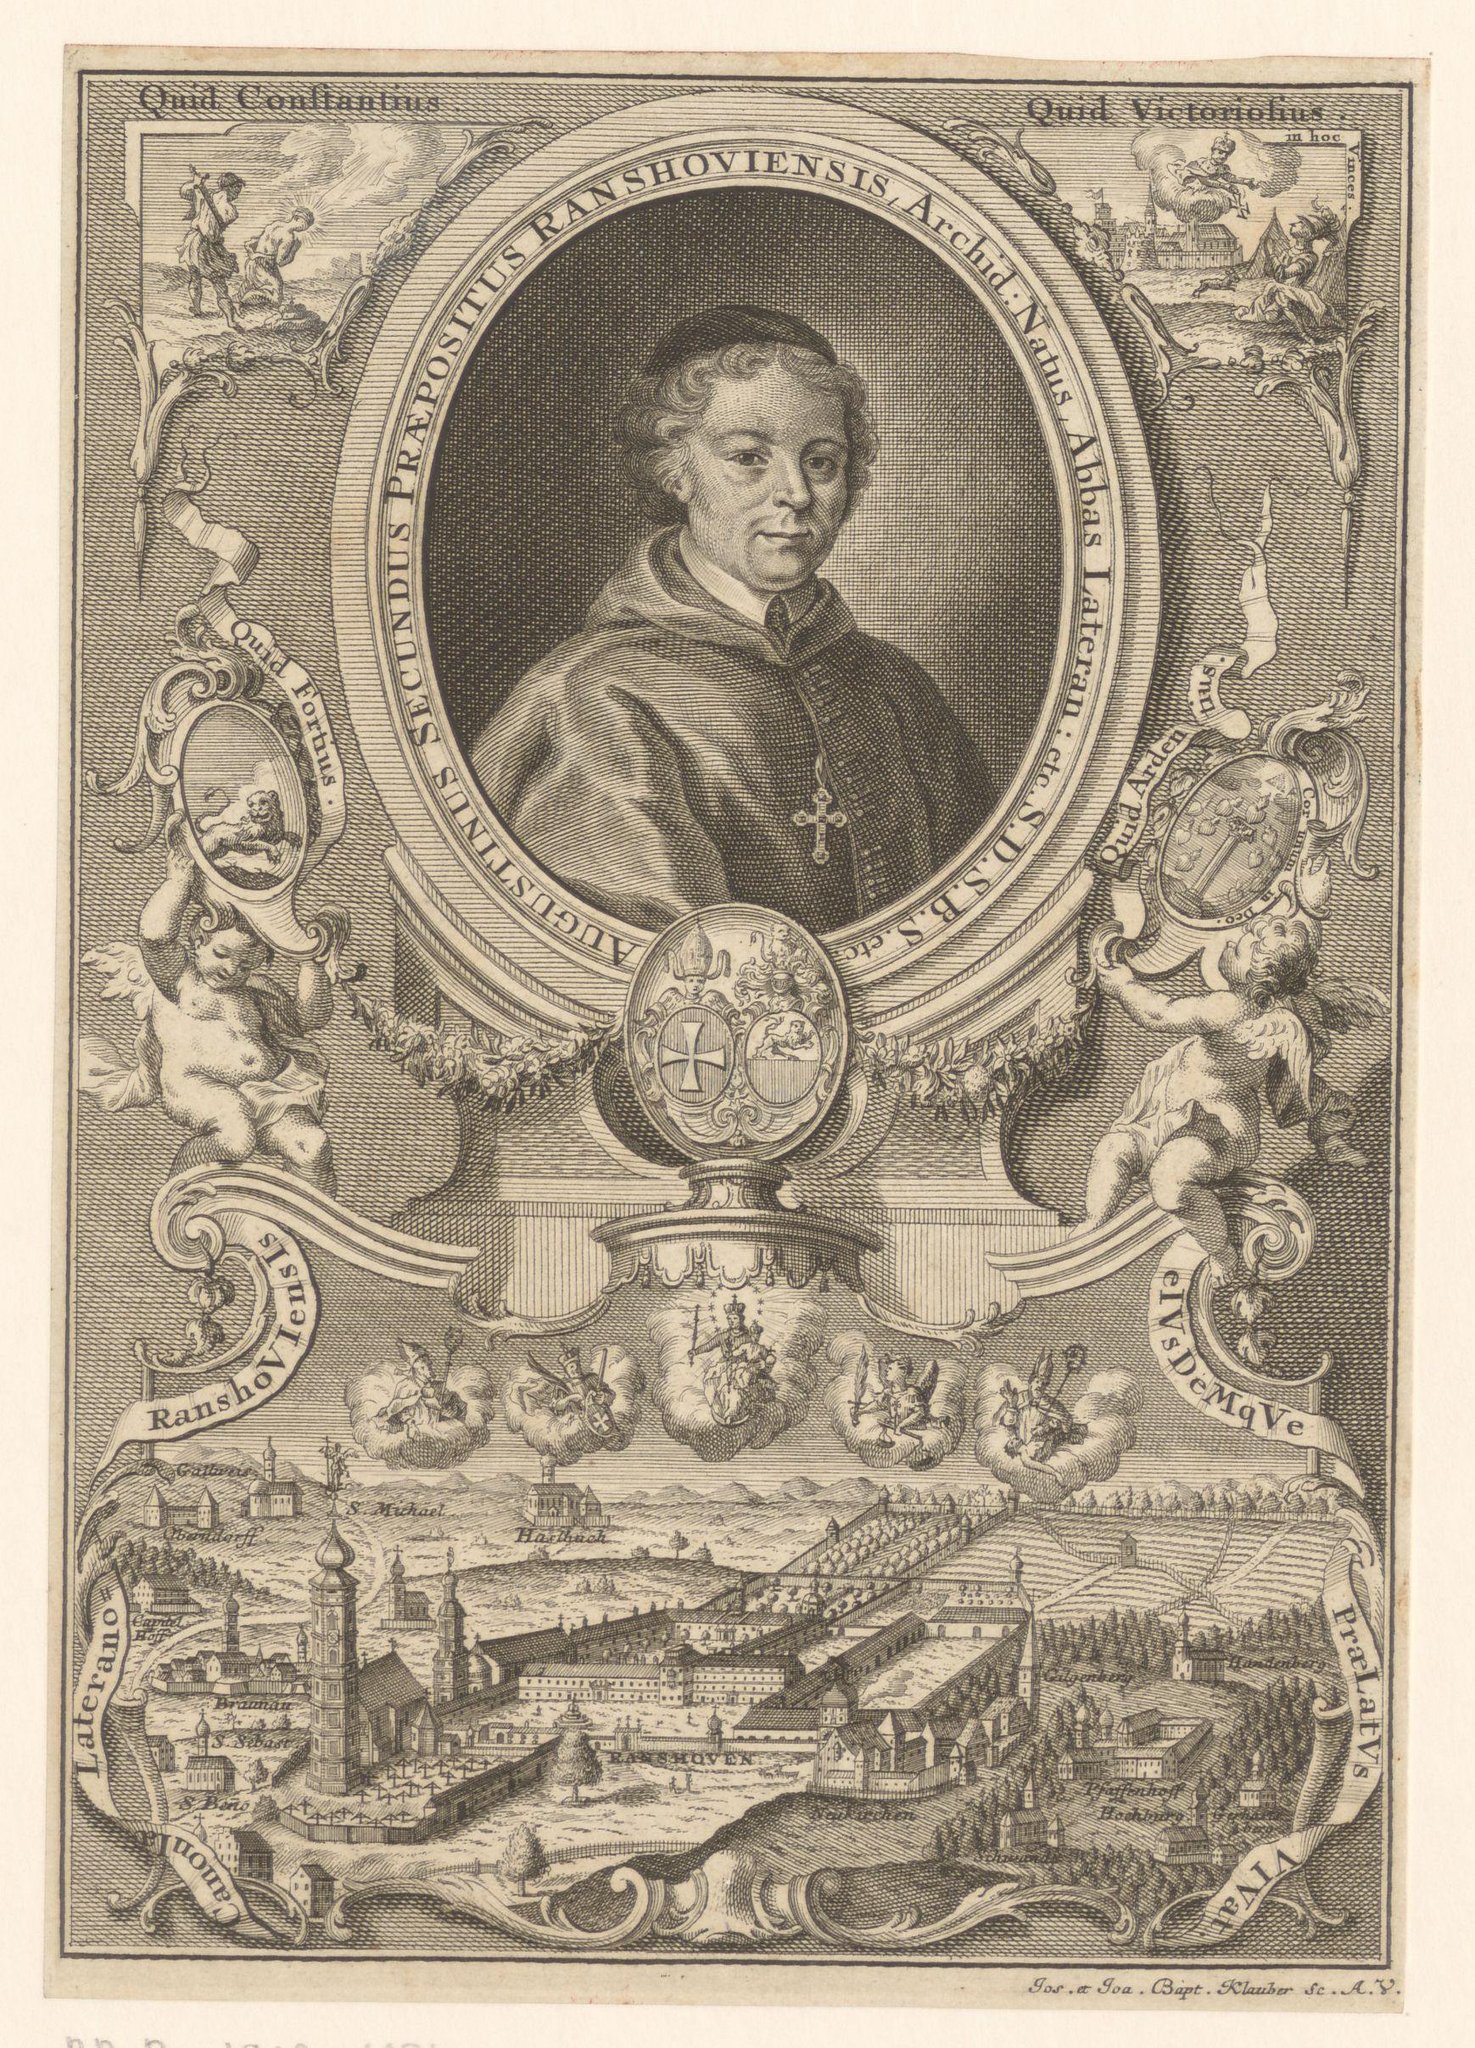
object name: print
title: Portret van Augustinus, provoost van Stift Ranshoven, met gezicht op het klooster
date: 1722-1768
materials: paper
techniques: engraving, etching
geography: augsburg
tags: theologian, historical persons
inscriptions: collector's mark: Lugt 2233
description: Tekst in het Latijn in de omlijsting, de banieren en als plaatsaanduidingen.